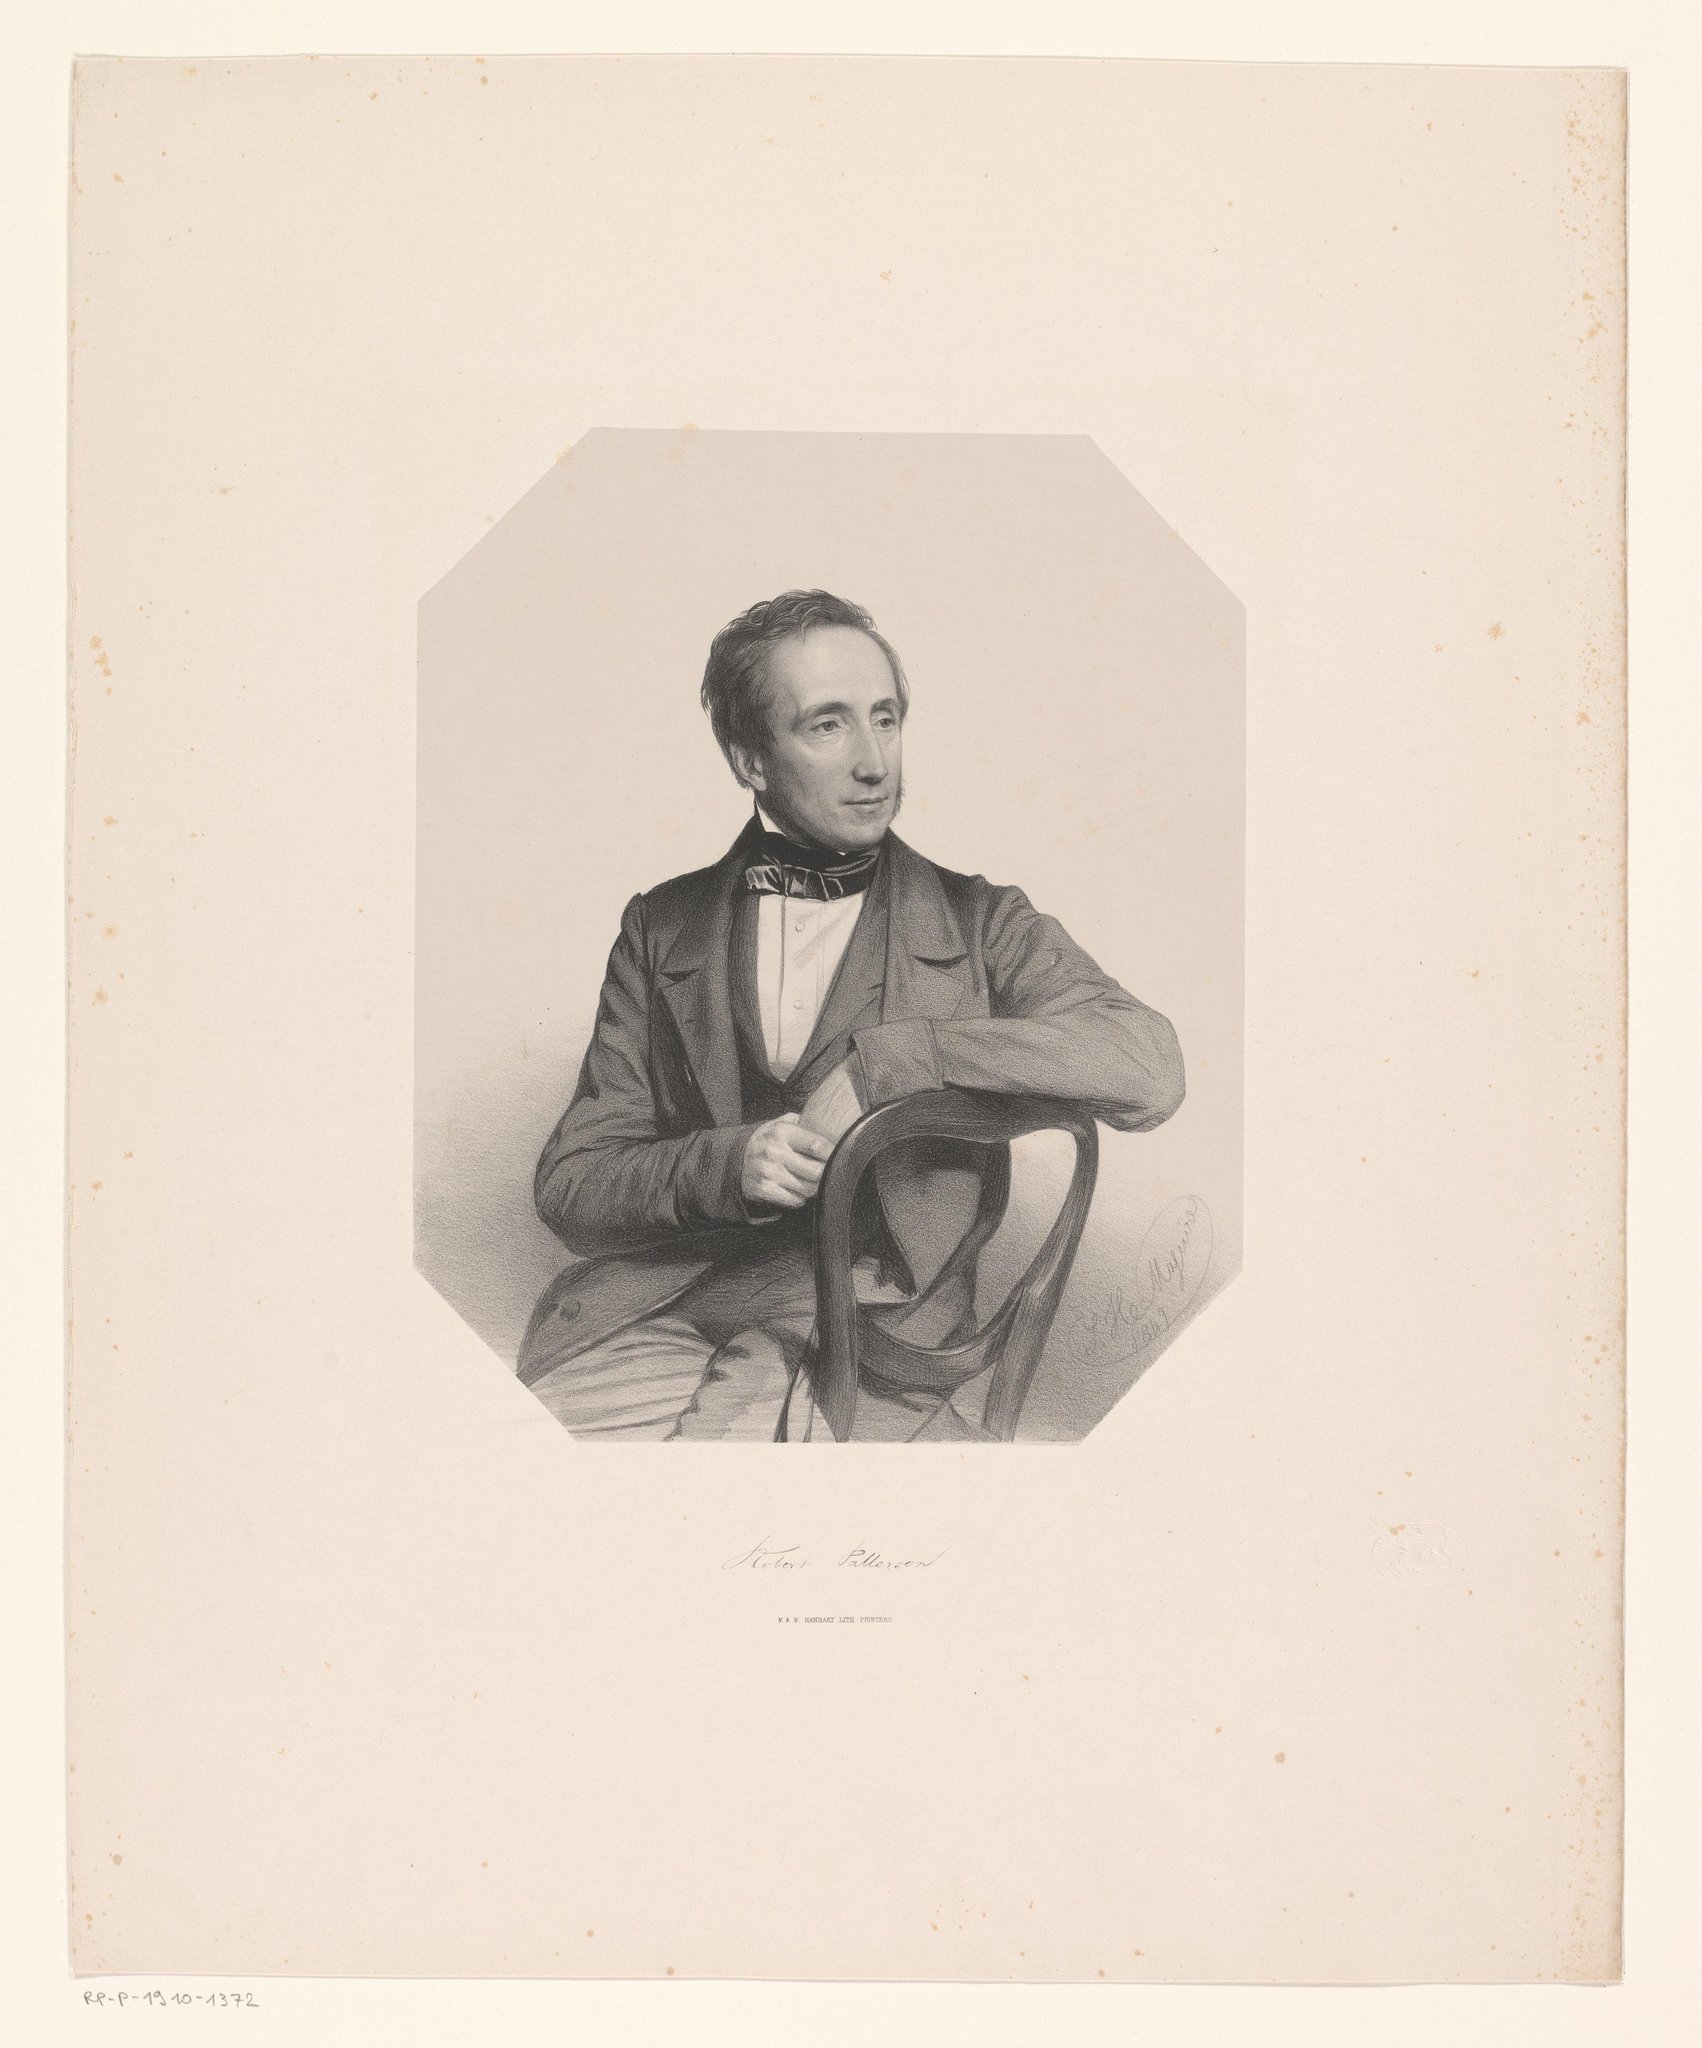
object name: print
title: Ipswich Museum Portraits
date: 1852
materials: paper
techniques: lithograph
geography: london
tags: adult man, historical persons, chair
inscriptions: check stamp: ‘Ipswich Museum’, collector's mark: Lugt 2228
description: Prent behoort tot de serie 'Ipswich Museum Portraits', ook bekend onder de titel 'Portraits of Honorary Members of the Ipswich Museum'. Deze serie is in 1852 door George Ransome uitgegeven en gedrukt door M&N Hanhart tussen 1848 en 1852. De serie bestaat uit ca. 60 portretten.